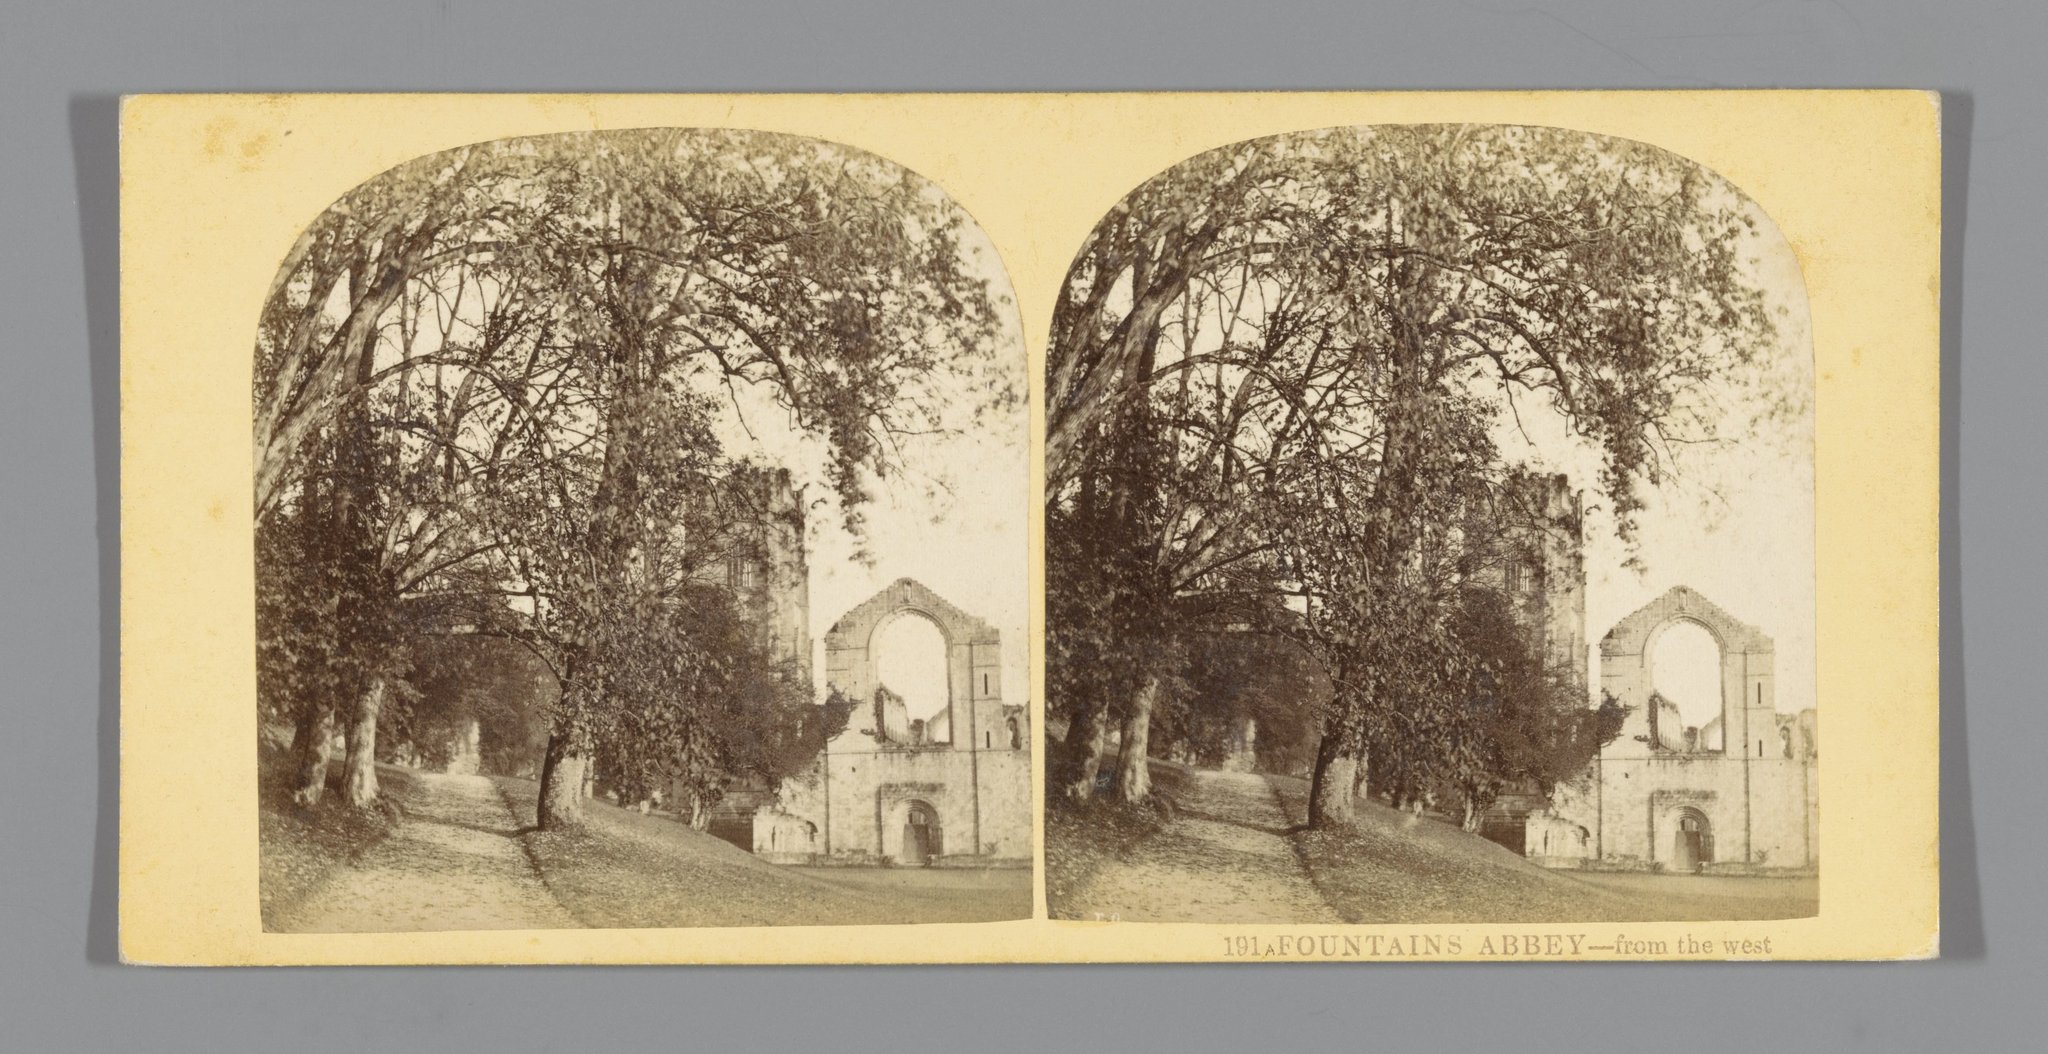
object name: stereograph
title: Gezicht op Fountains Abbey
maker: Anonymous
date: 1850-1880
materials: cardboard, photographic support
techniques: albumen print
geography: fountains abbey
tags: ruin of church, monastery, etc.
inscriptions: number: ‘191A’